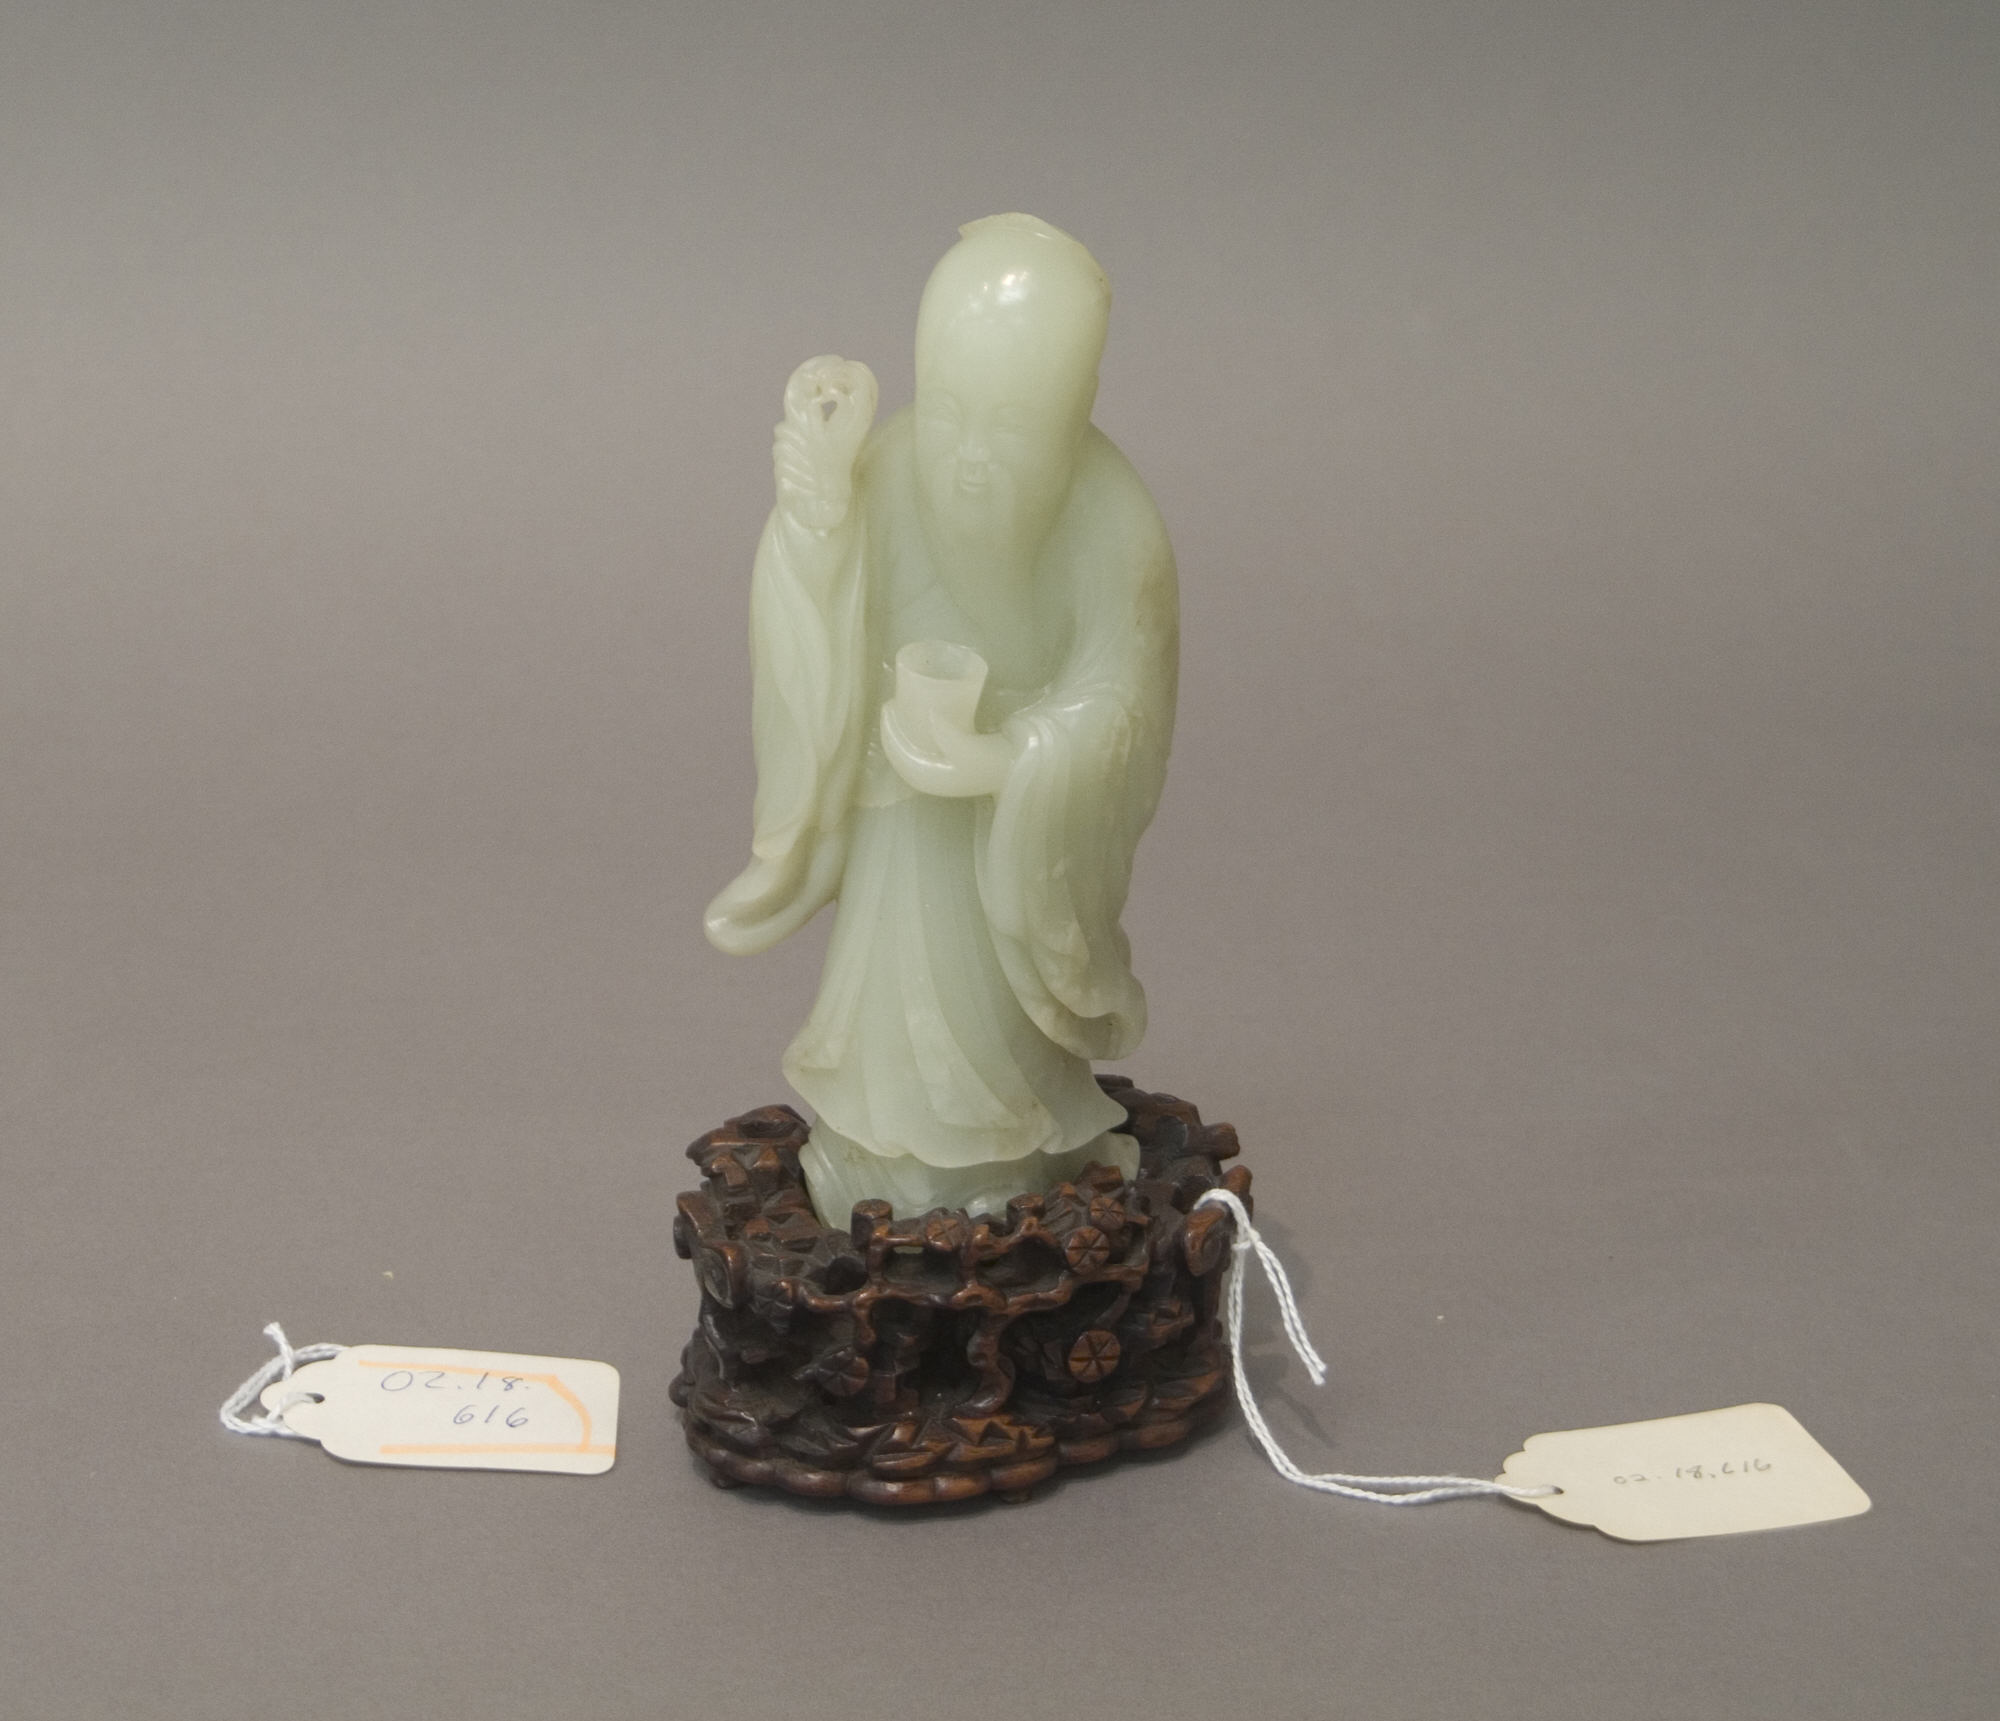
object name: figure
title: Daoist Immortal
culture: chinese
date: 1667-1733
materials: jade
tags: men,daoism